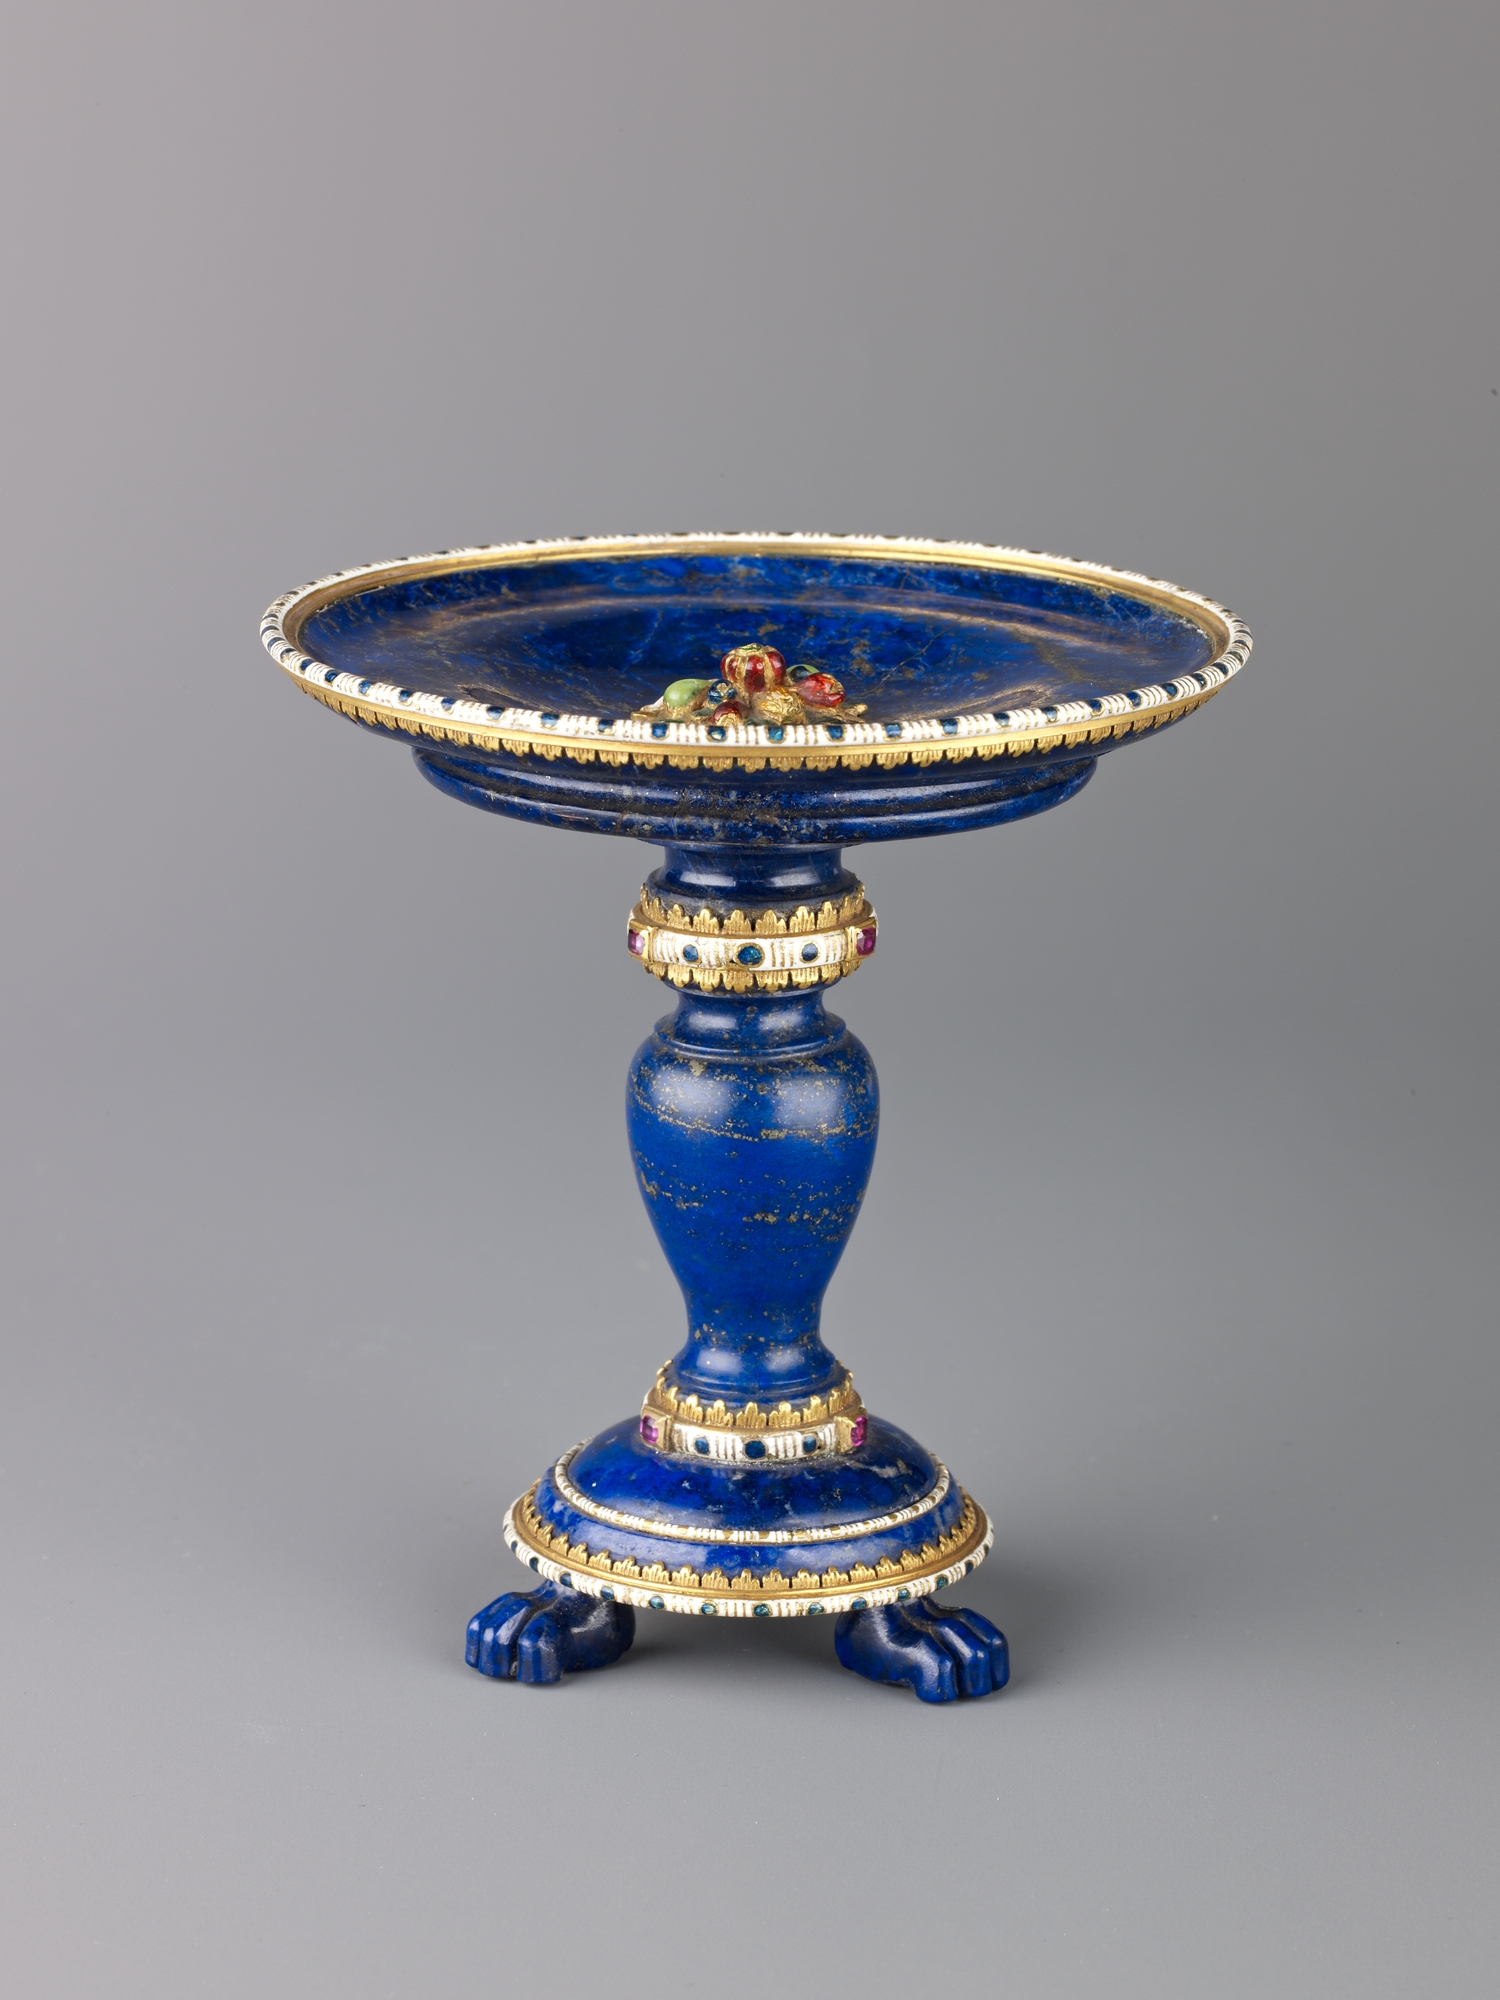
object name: cup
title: Tazza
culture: french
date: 1876-1900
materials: enamel, gold, lapis lazuli, gemstone